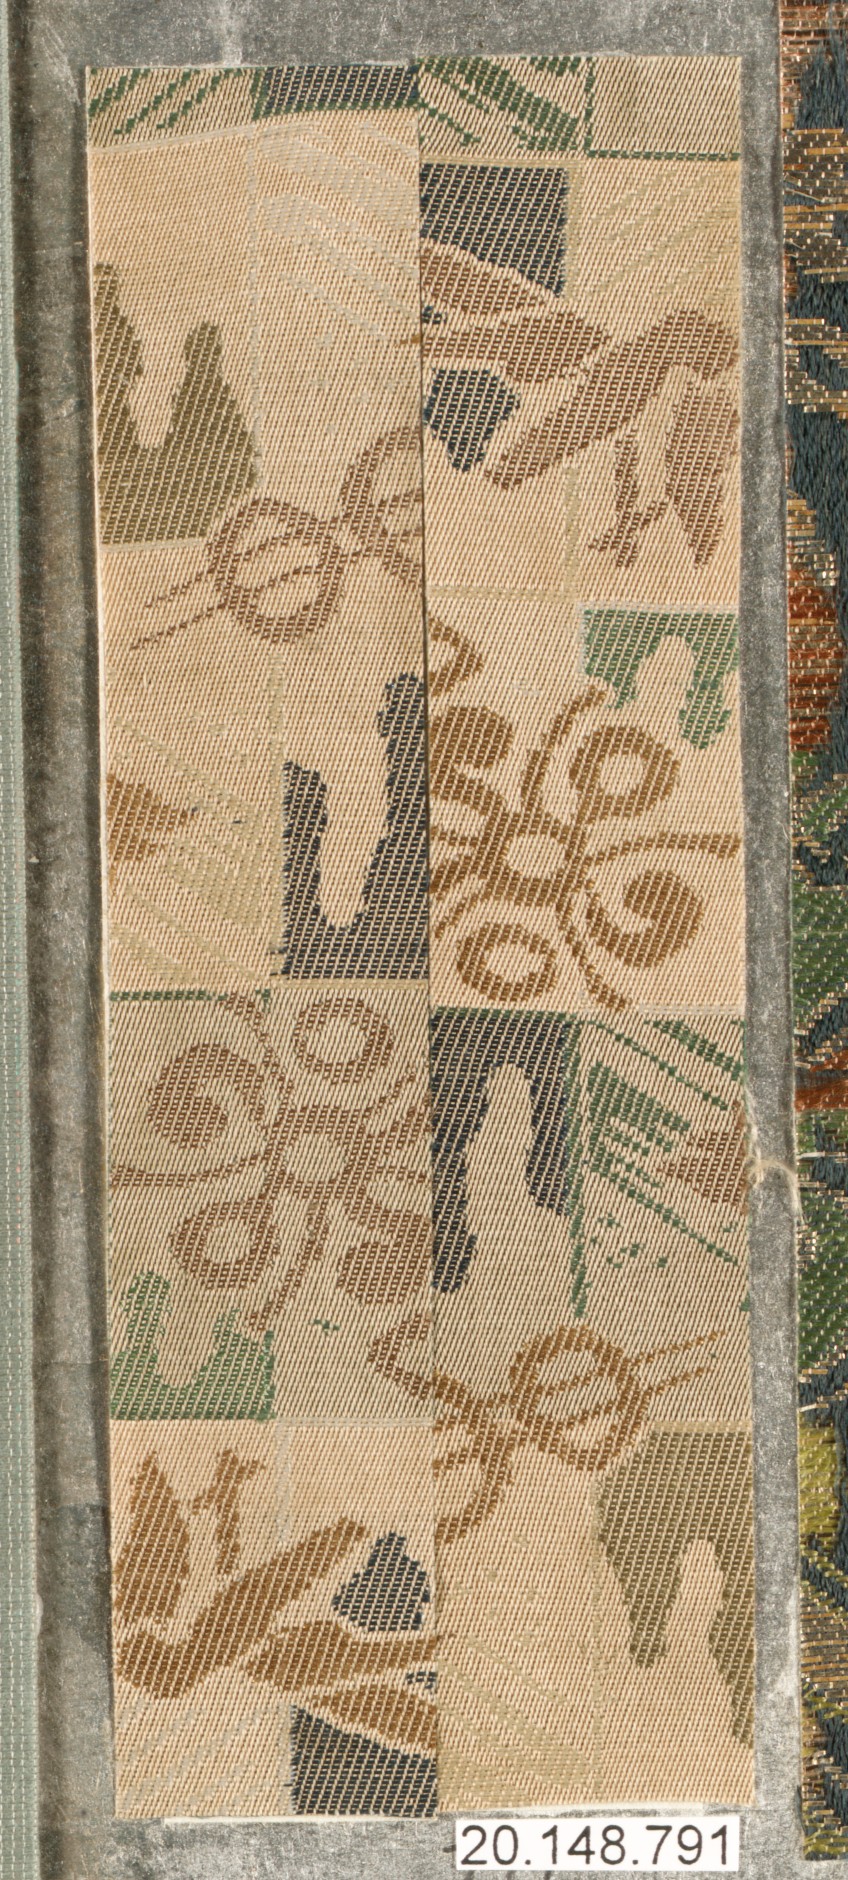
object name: piece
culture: japanese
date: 1701-1800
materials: silk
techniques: compound weave